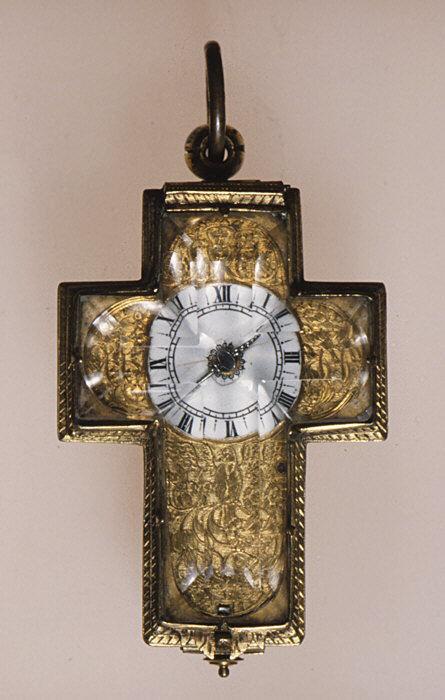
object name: watch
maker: pierre-martin scheult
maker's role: maker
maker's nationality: french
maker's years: 1600-1700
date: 1650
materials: enamel, quartz, silver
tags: cross